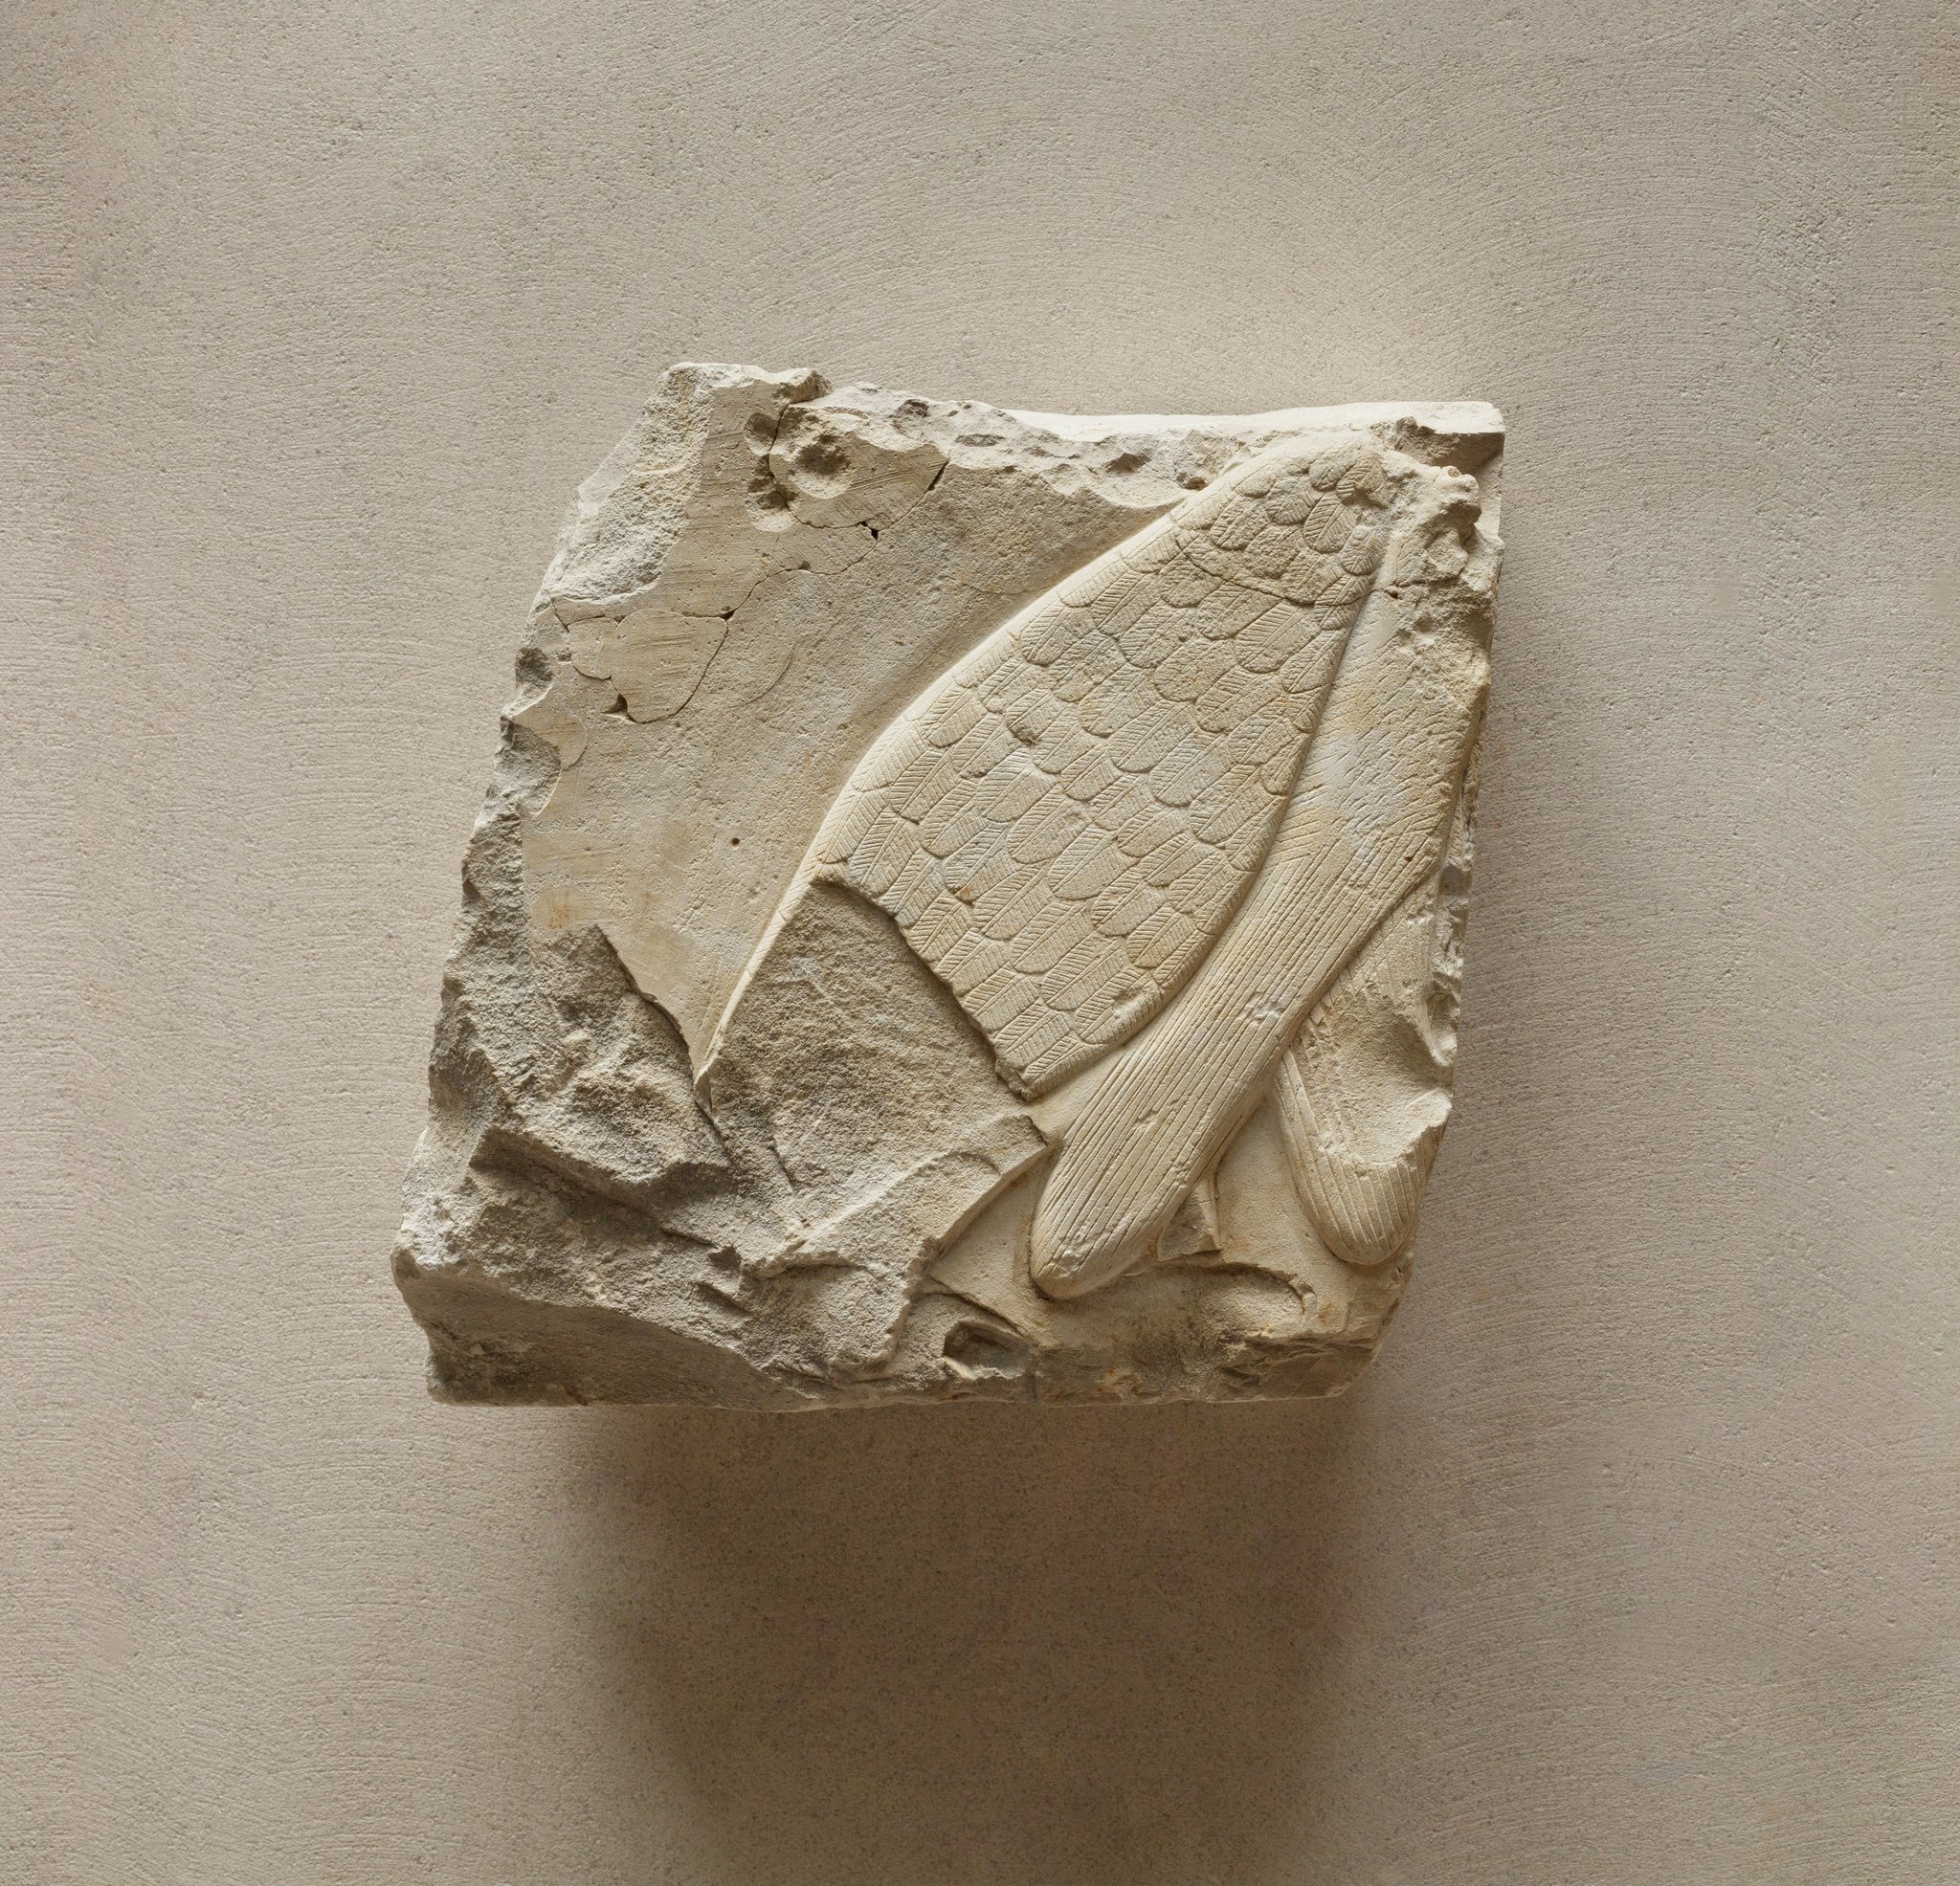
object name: relief, fragment from a row of vulture, neferu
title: Relief fragment from a row of vulture figures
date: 2051-2030 BCE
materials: limestone, paint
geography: egypt